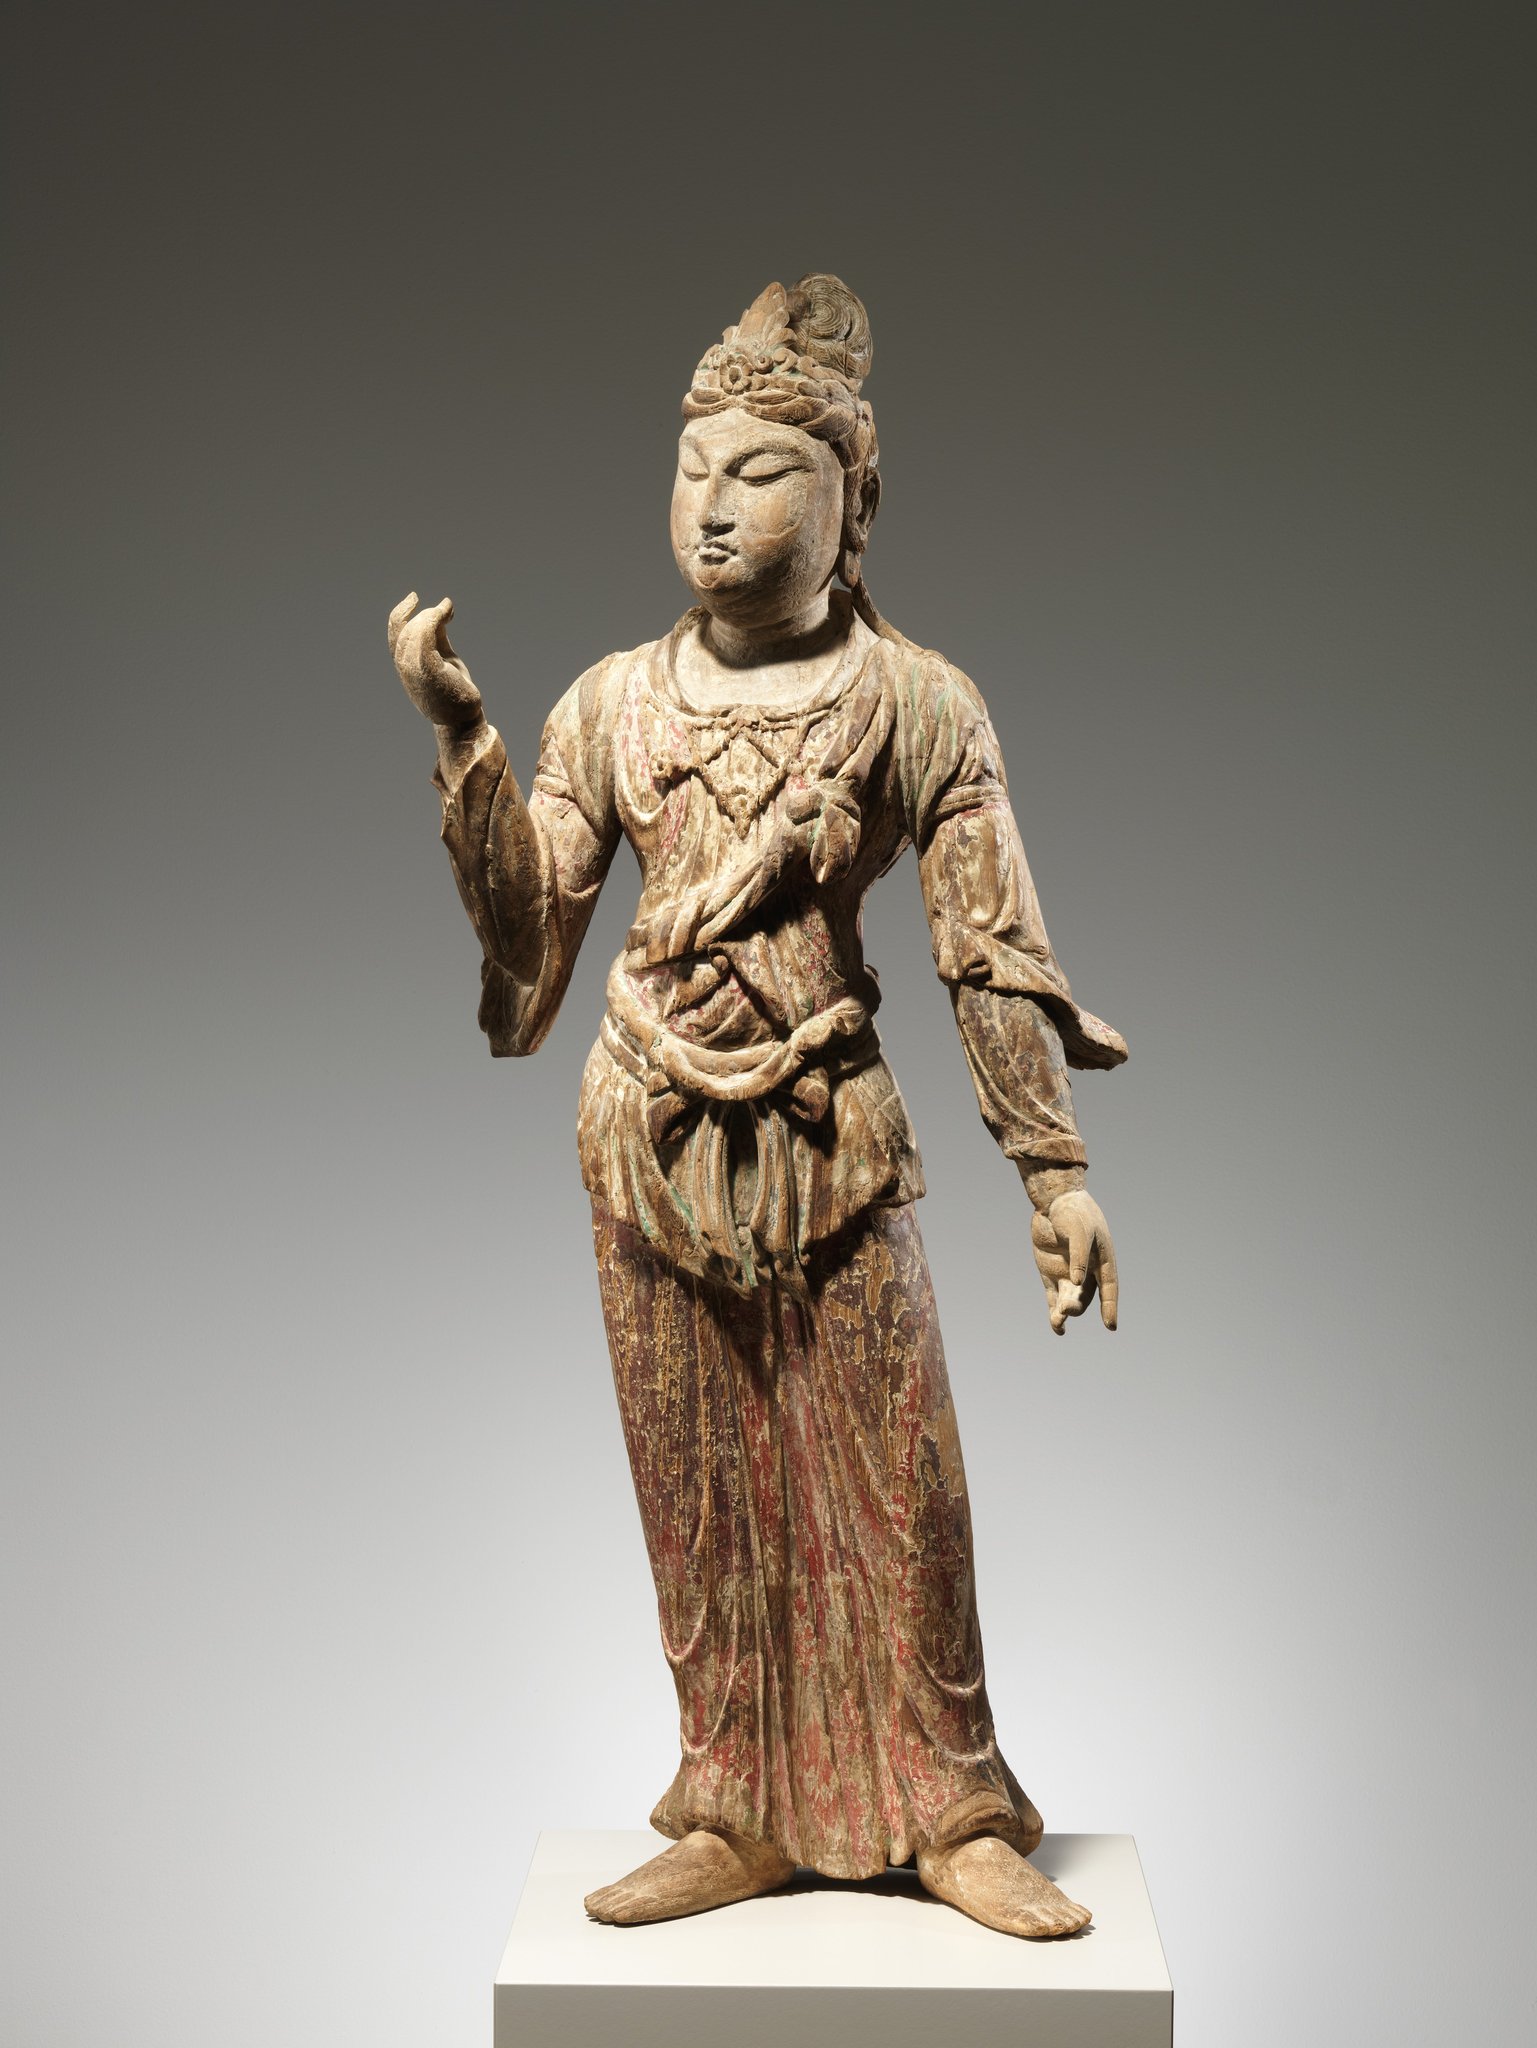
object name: figure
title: Attendant Bodhisattva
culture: chinese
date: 901-1100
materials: pigment, wood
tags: buddhism,bodhisattvas